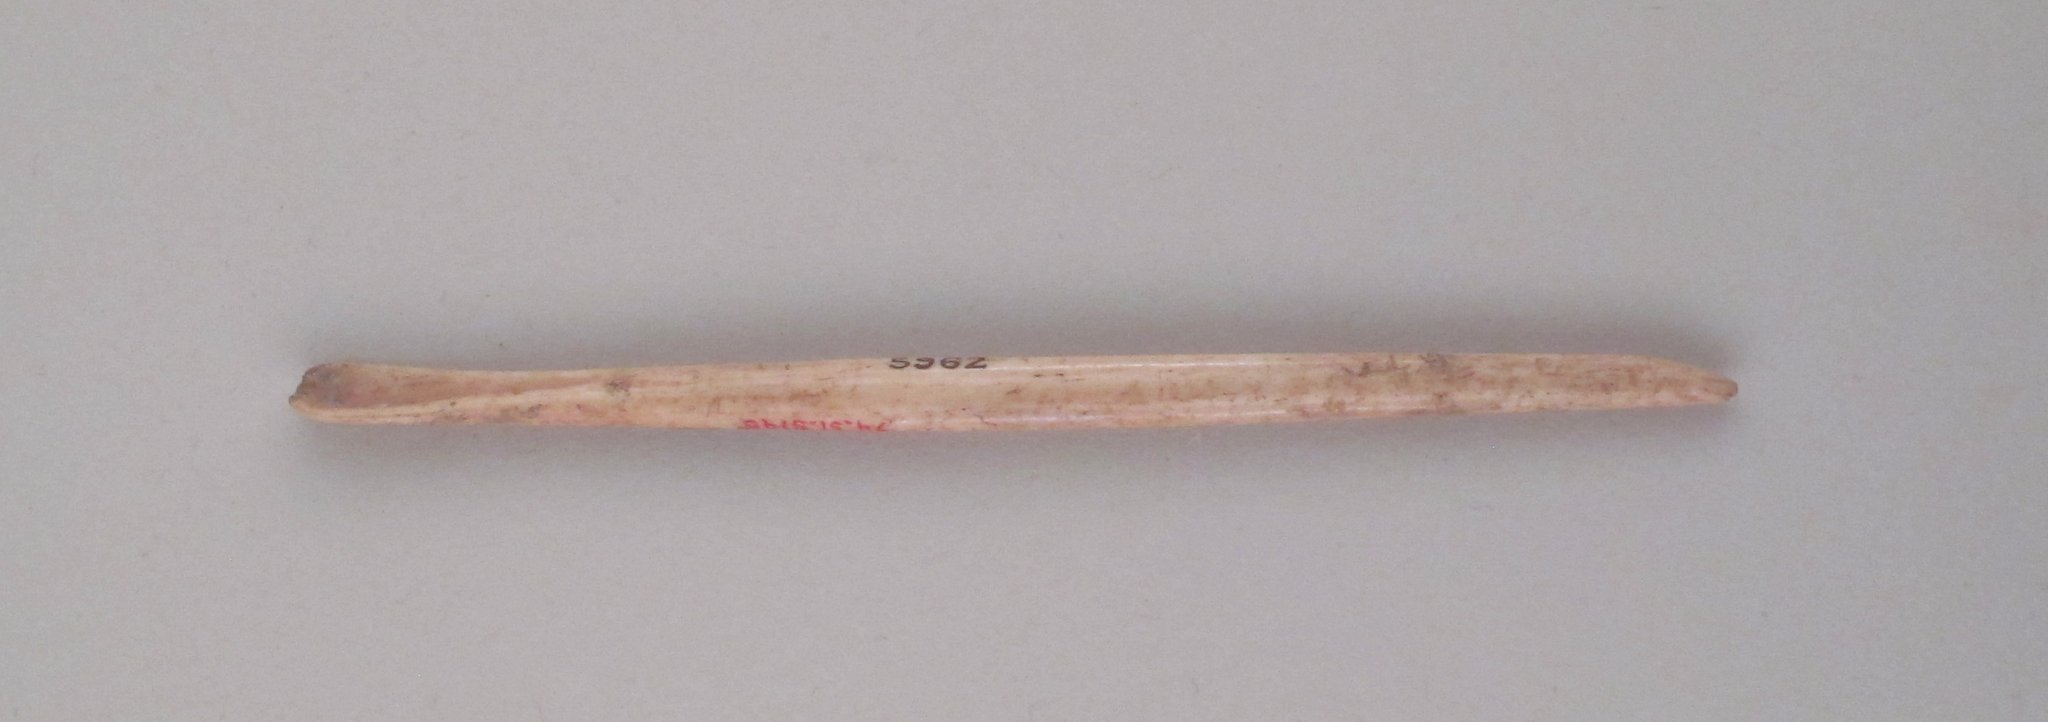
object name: ear pick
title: Bone ear pick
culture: cypriot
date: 7000 BCE-330 CE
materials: bone